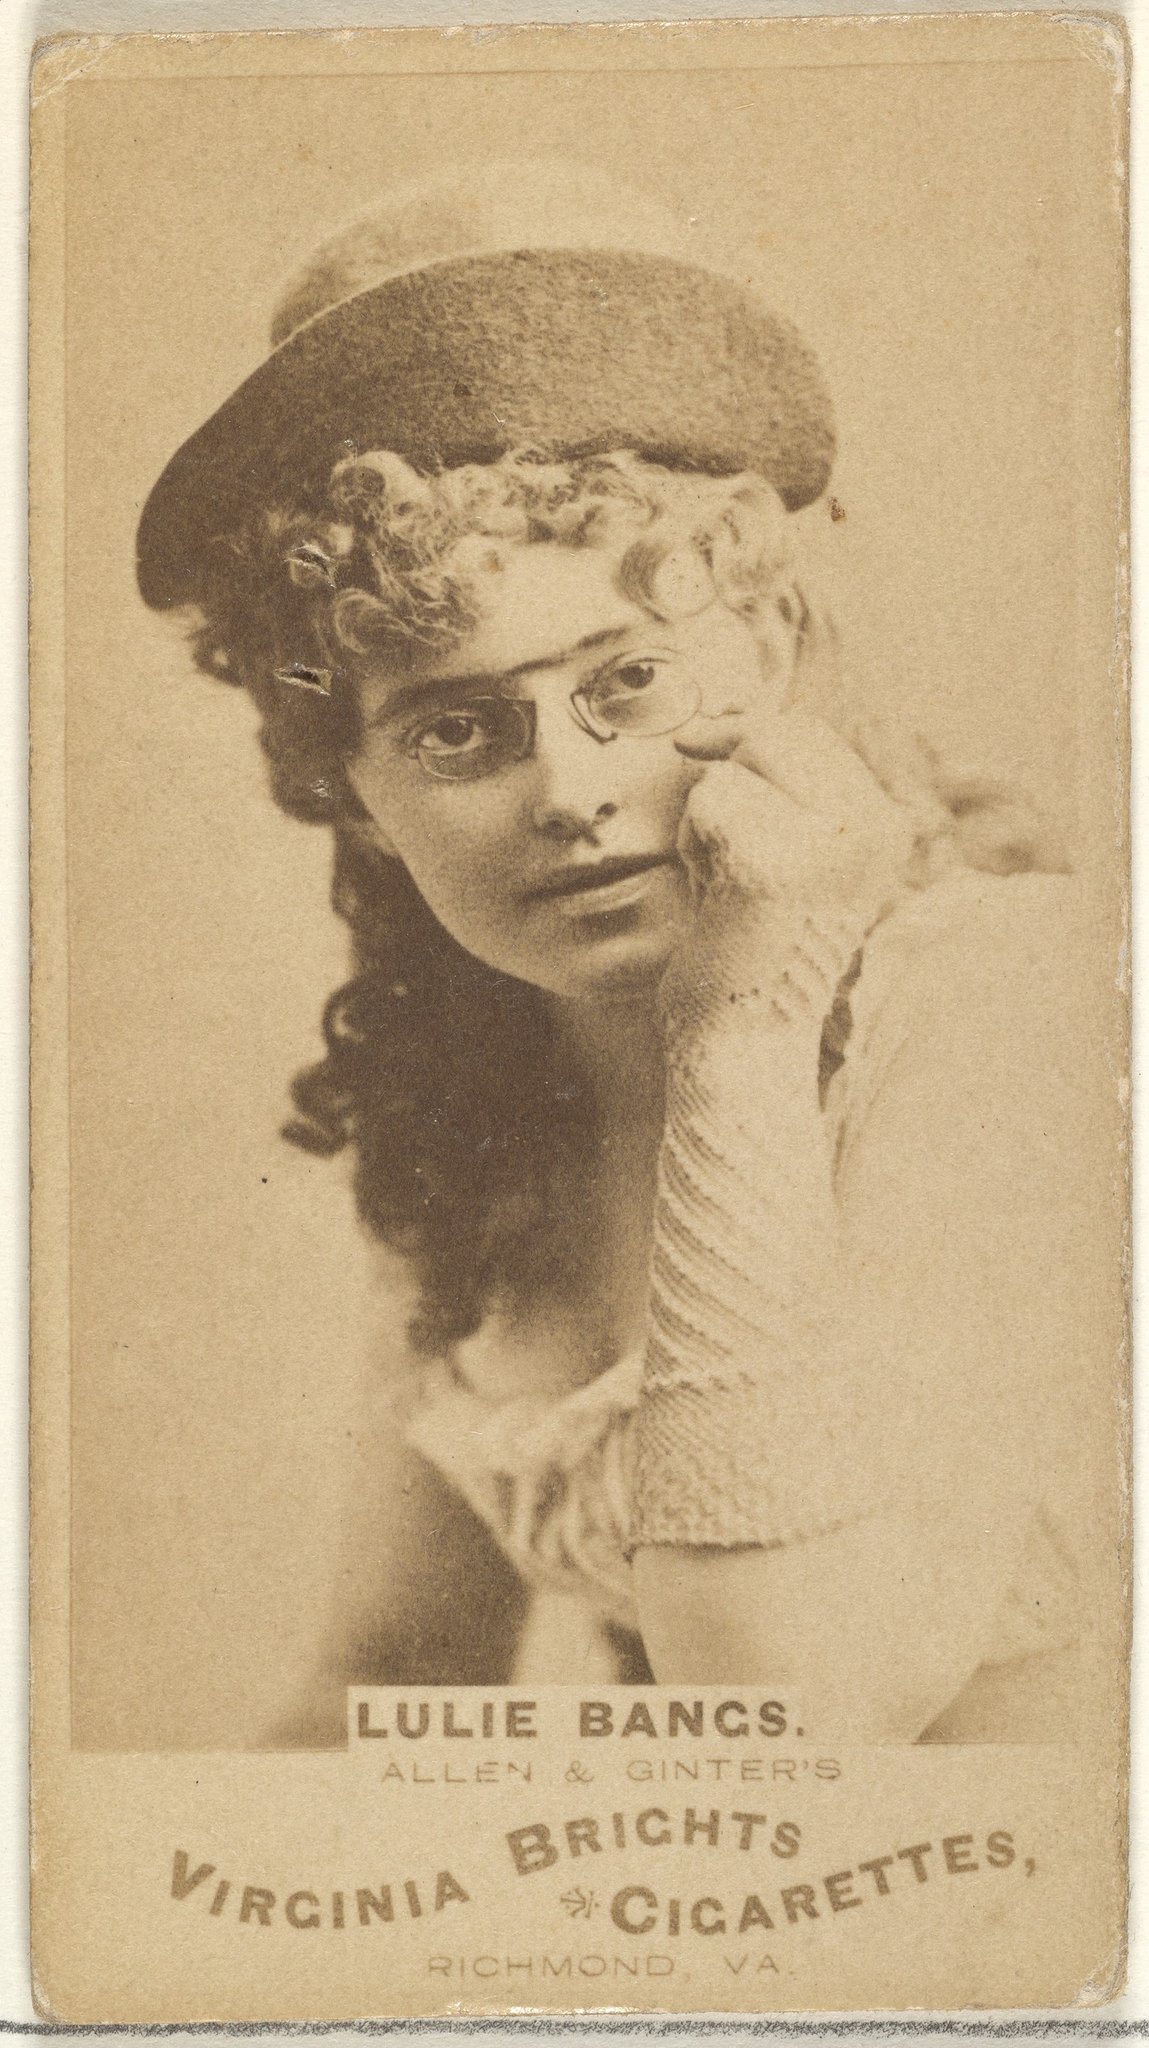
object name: photograph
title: Lulie Bangs, from the Actors and Actresses series (N45, Type 1) for Virginia Brights Cigarettes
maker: allen & ginter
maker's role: publisher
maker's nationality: american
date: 1888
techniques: albumen silver print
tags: portraits,women,actresses